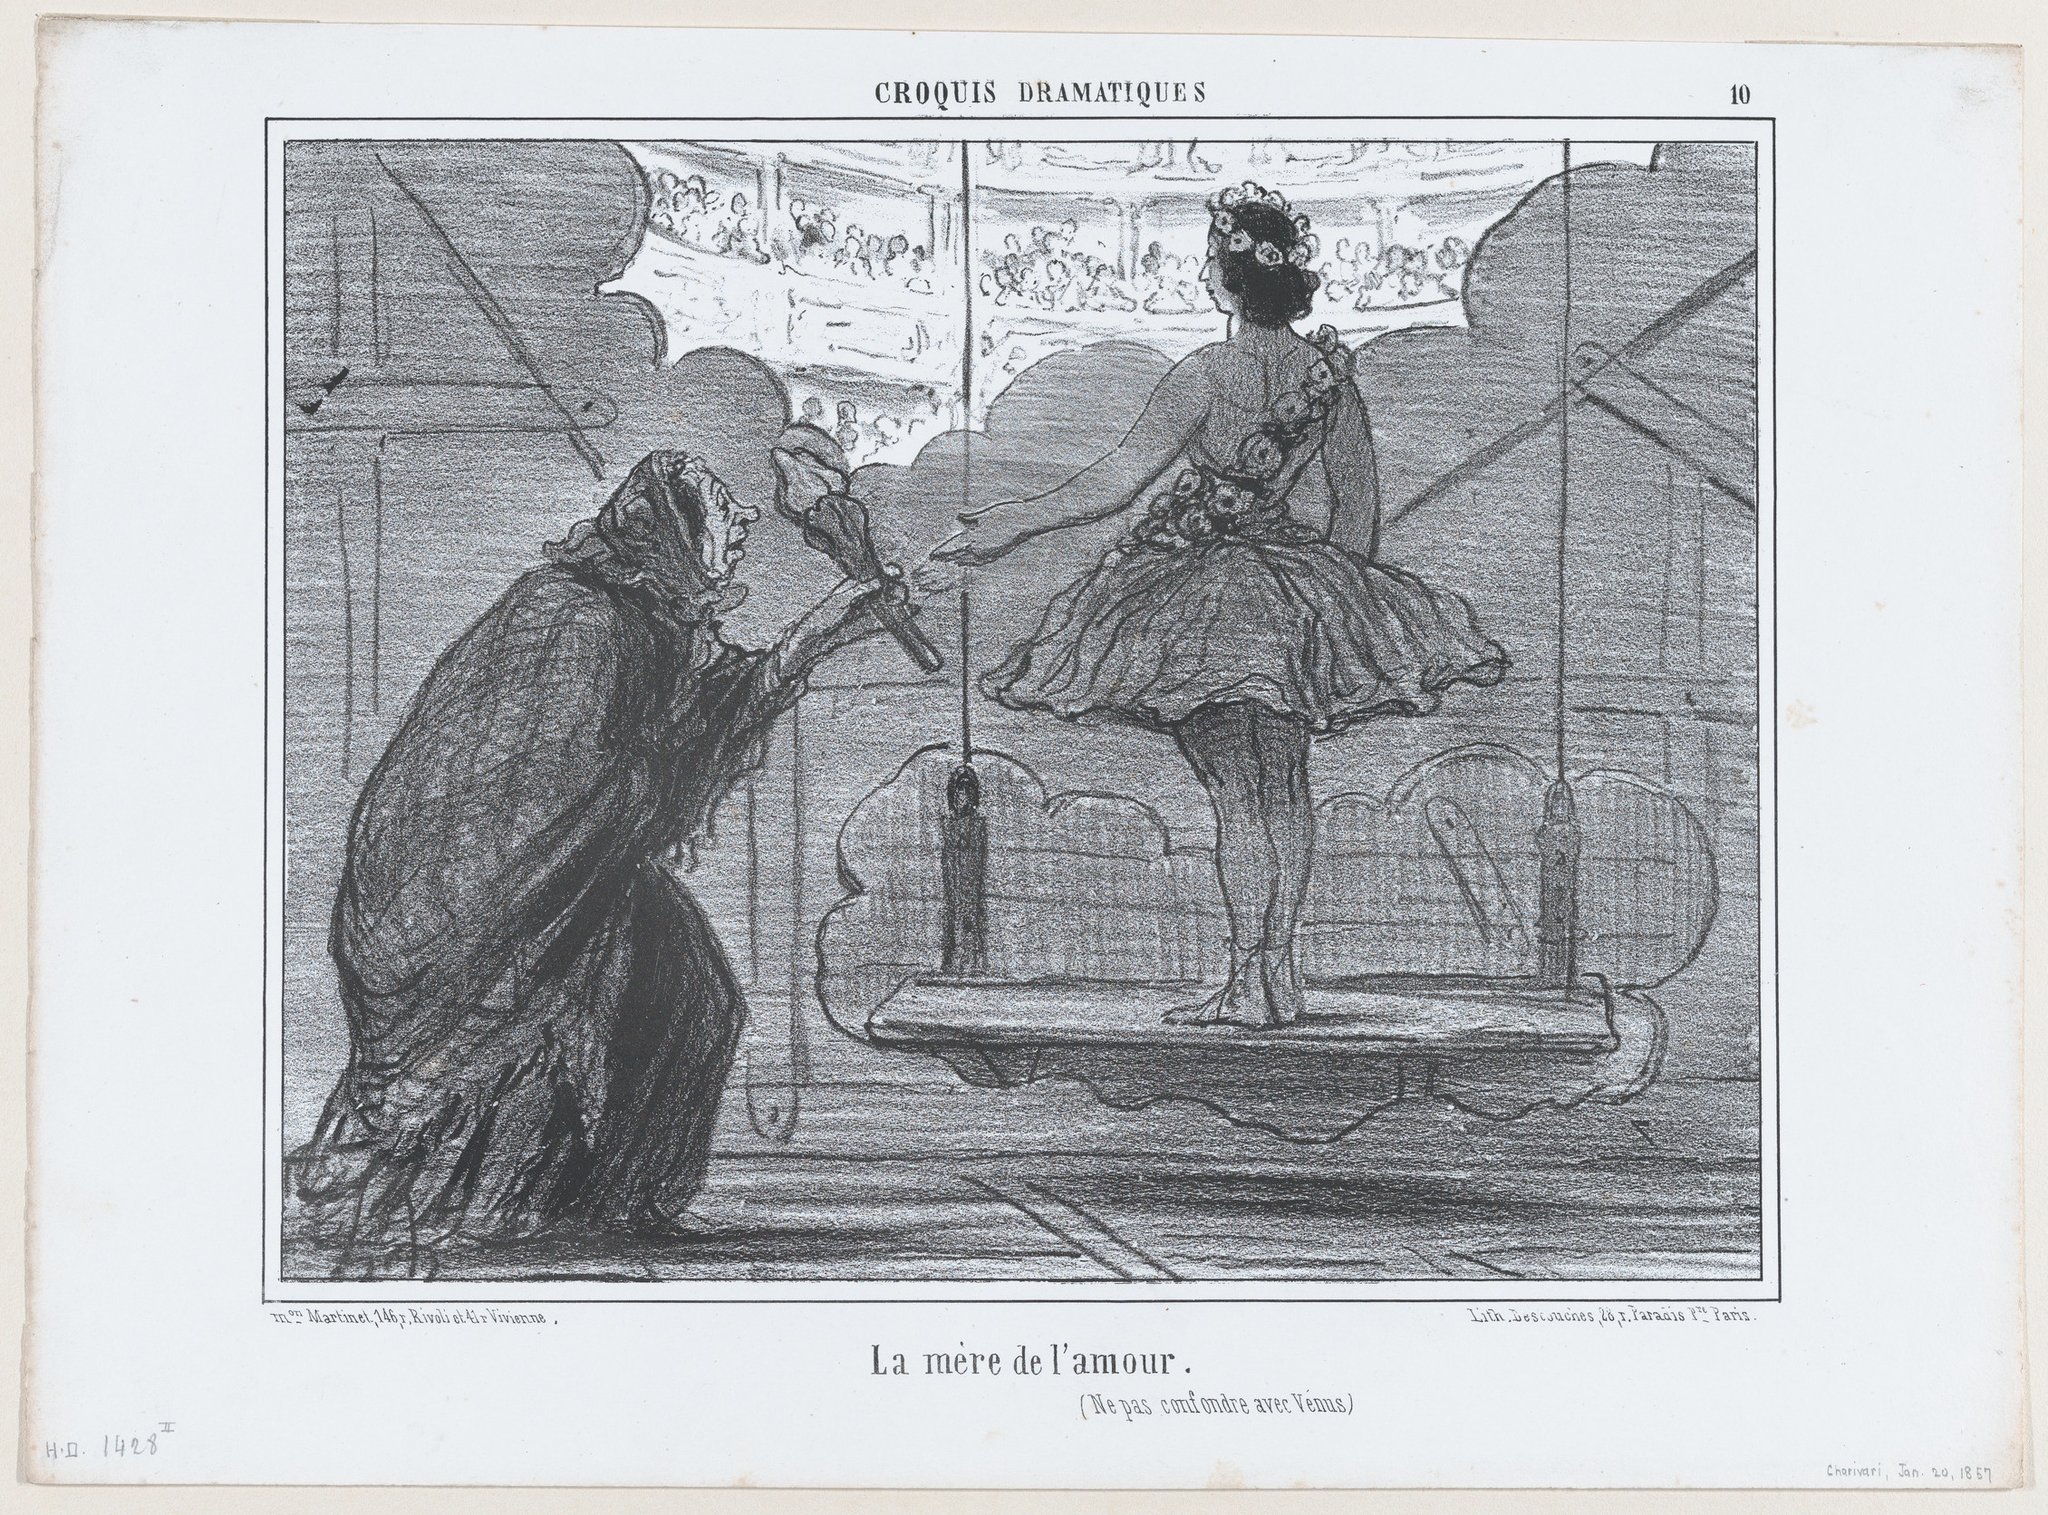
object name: print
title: La mère de l'amour...., from Croquis Dramatiques, published in Le Charivari, January 20, 1857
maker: honoré daumier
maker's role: artist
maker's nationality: french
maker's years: 1808-1879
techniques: lithograph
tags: satire,women